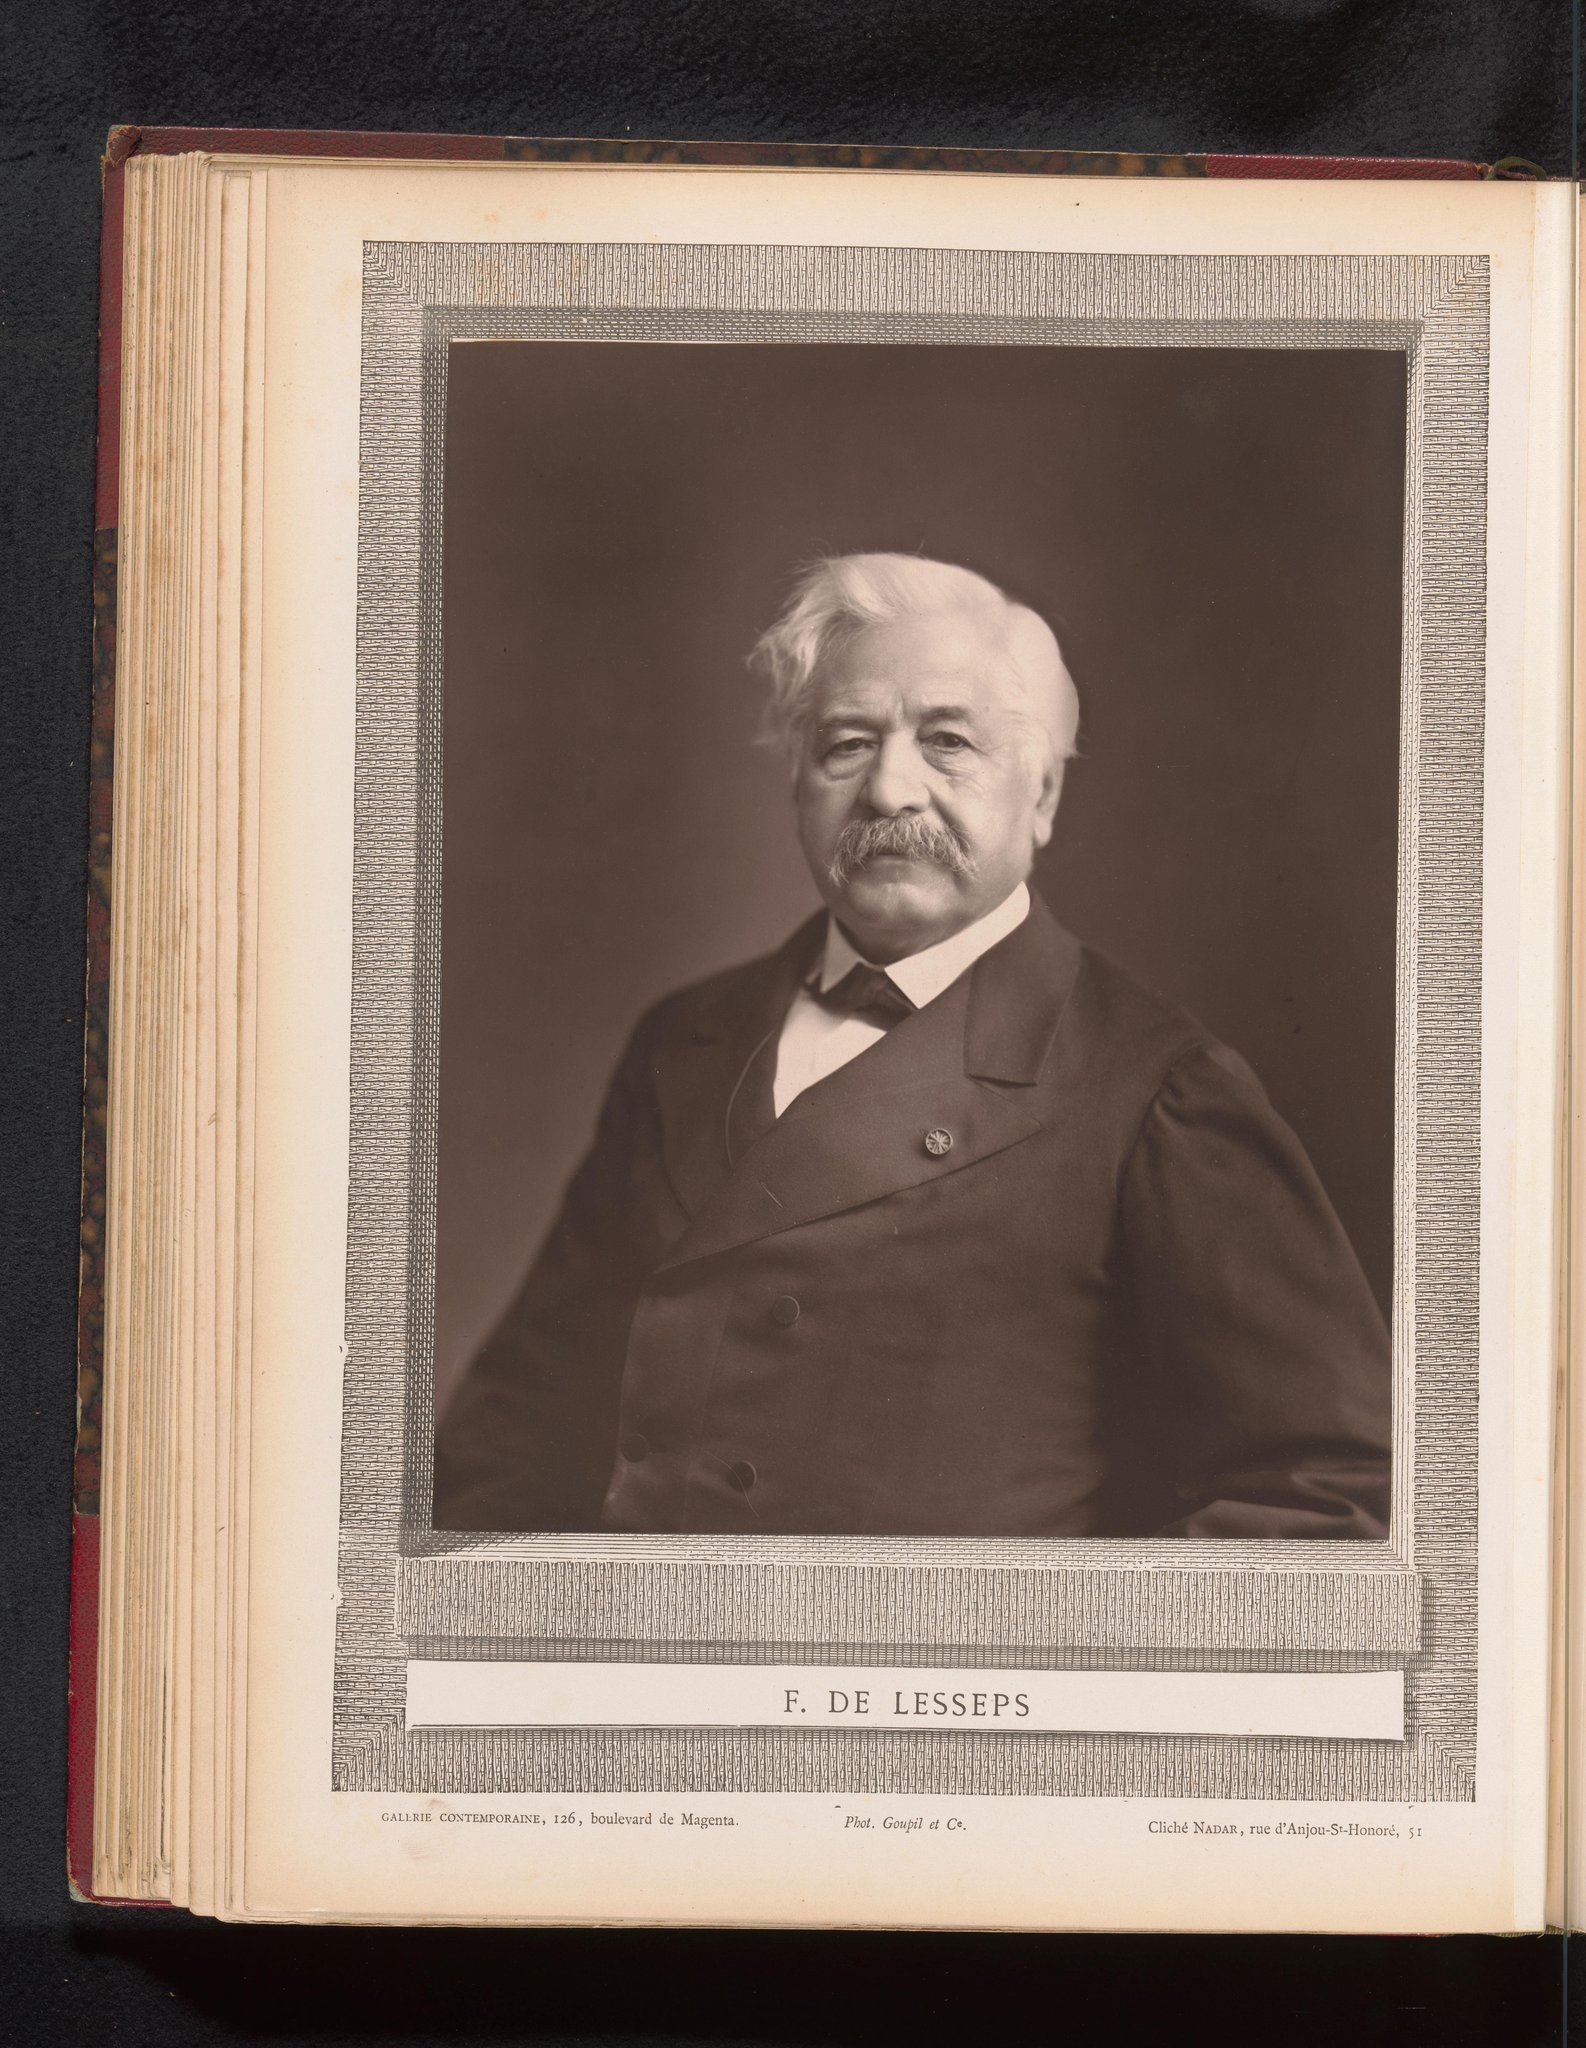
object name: photomechanical print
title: Ferdinand de Lesseps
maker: félix nadar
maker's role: ballonvaarder, fotograaf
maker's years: 1820-1910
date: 1871-1876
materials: paper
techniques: woodburytype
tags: engineer, adult man, historical persons